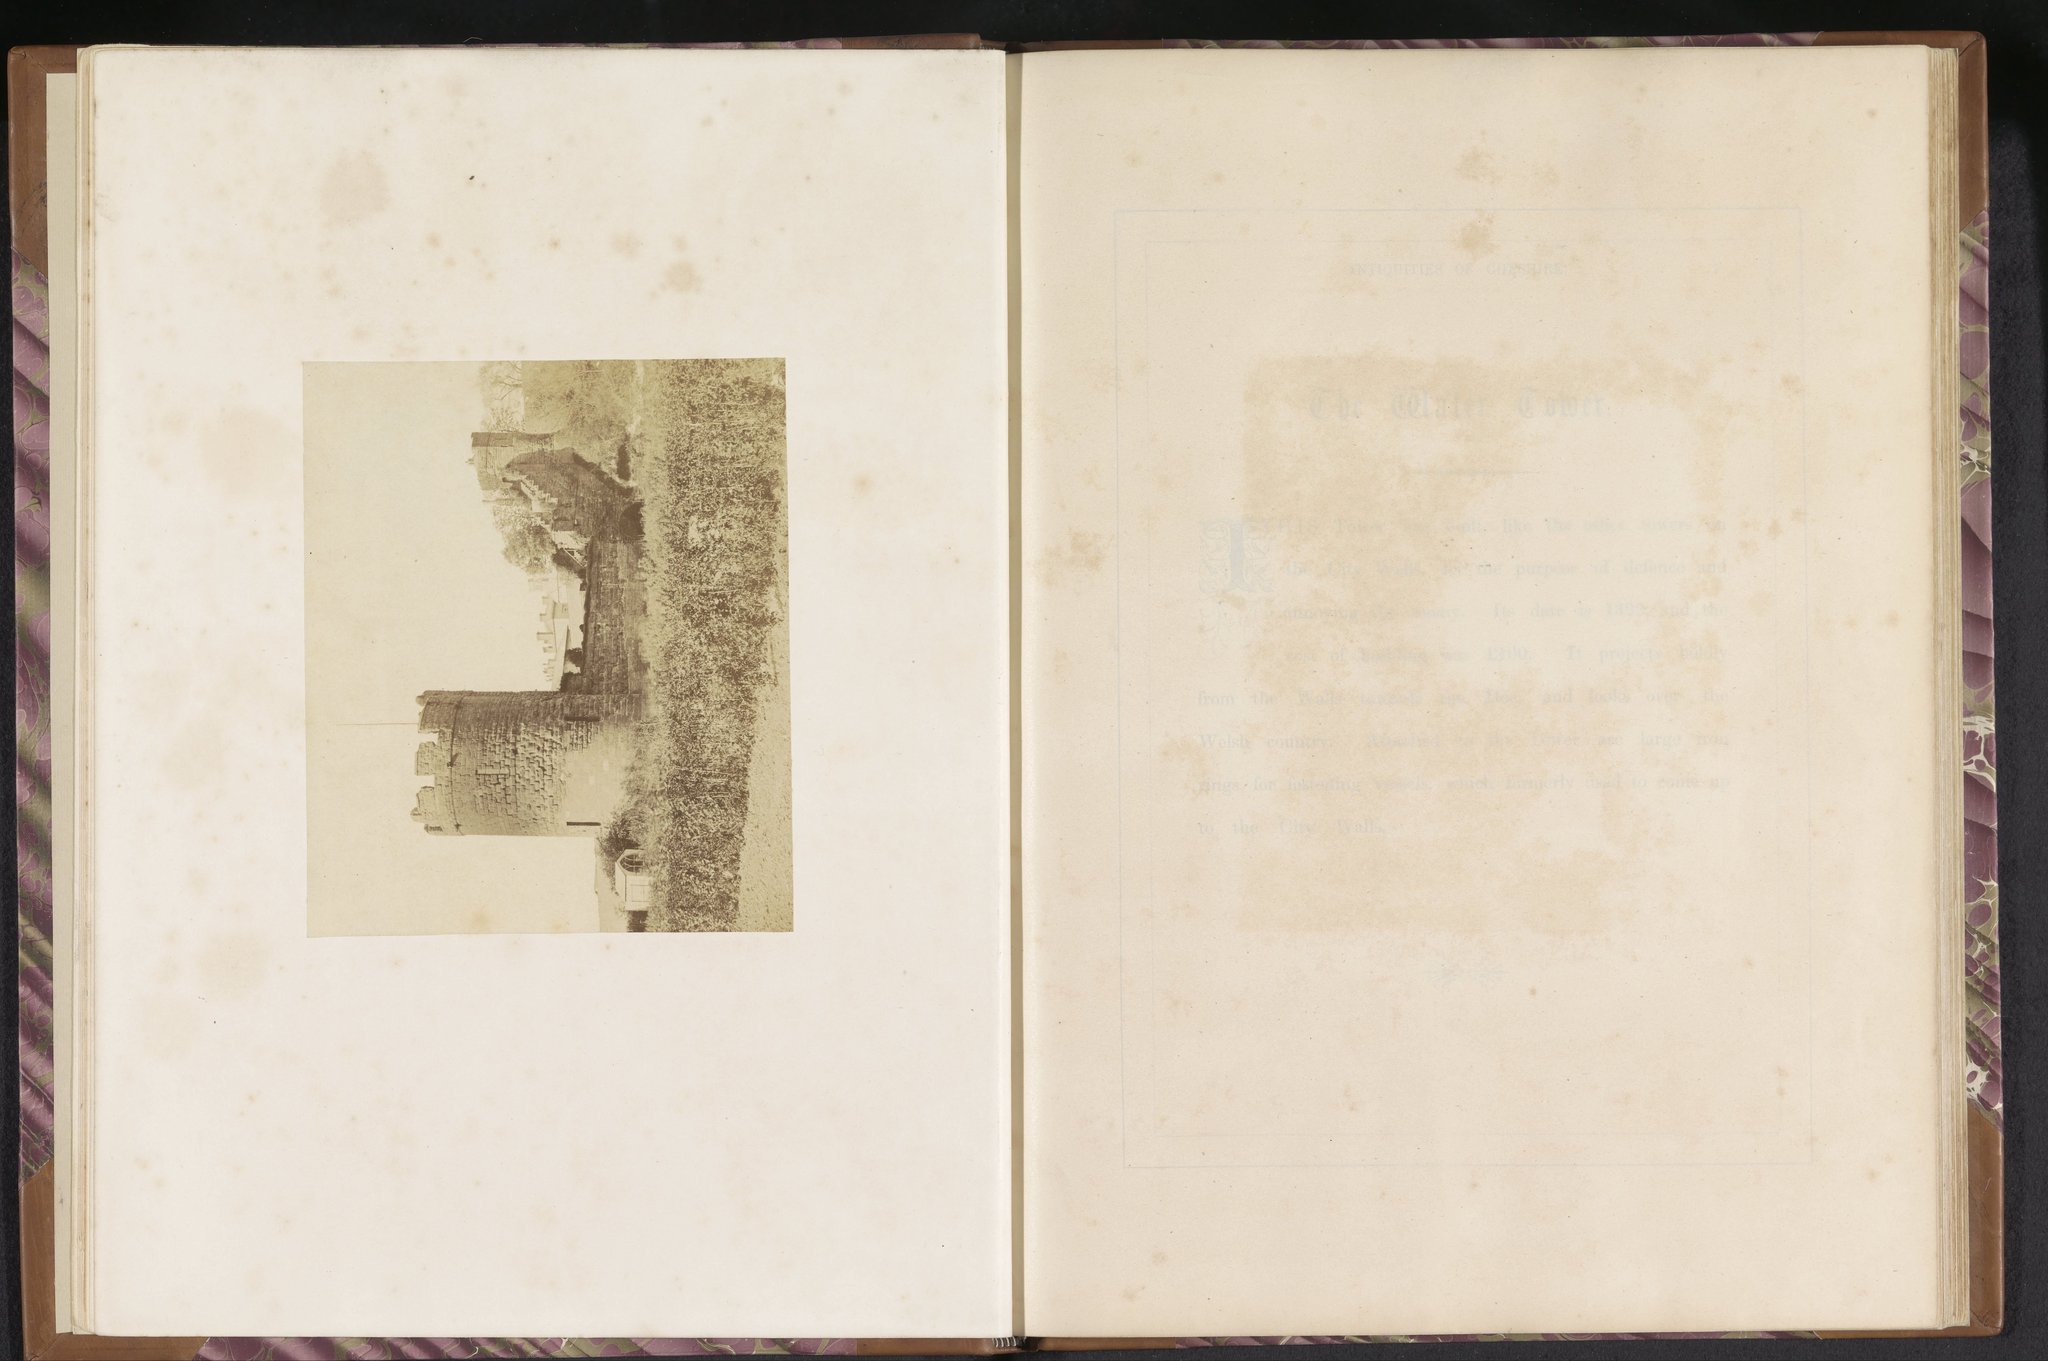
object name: photograph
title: The Water Tower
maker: william bryans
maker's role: fotograaf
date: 1850-1858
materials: photographic support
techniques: albumen print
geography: cheshire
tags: towers ~ fortified city